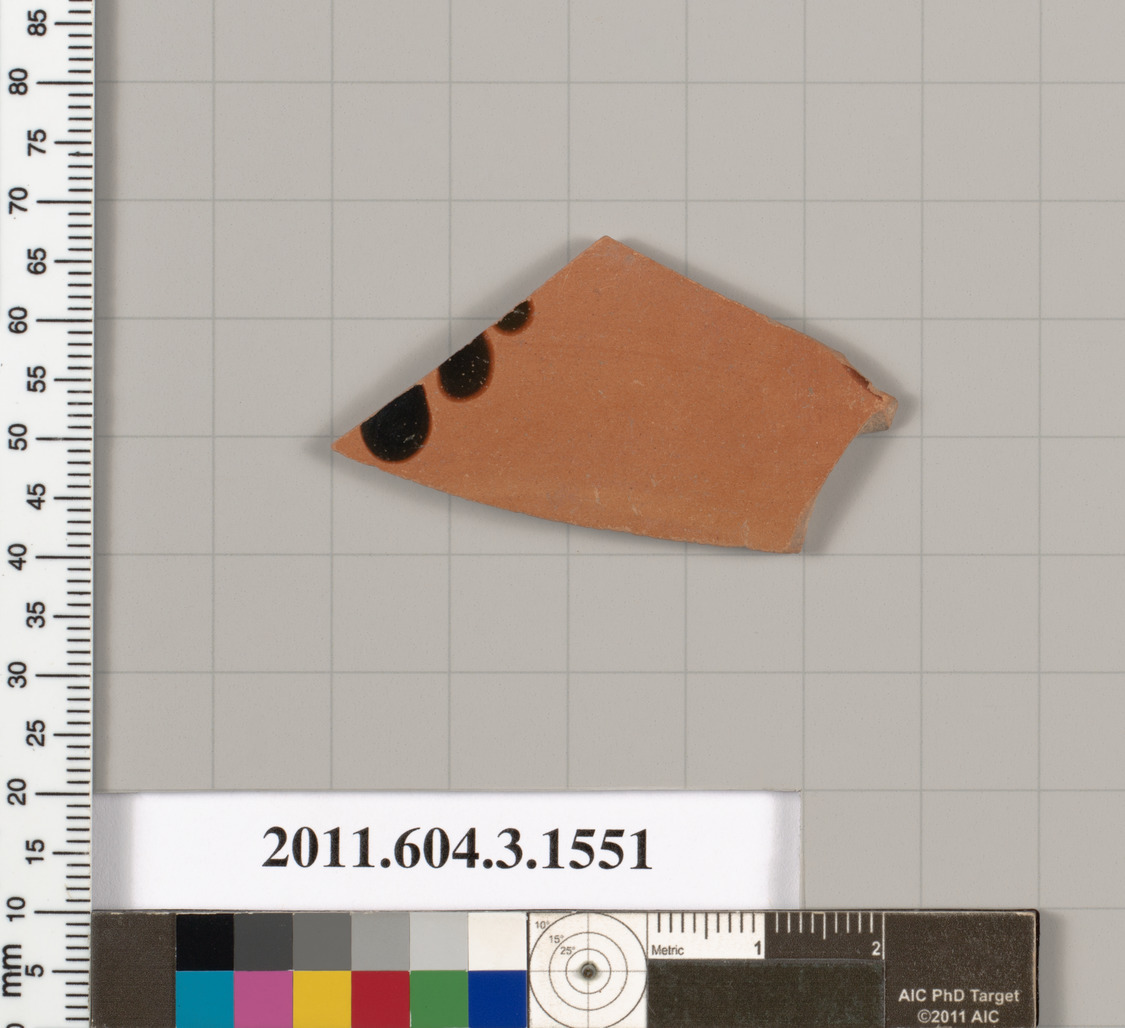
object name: kylix fragment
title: Terracotta fragment of a kylix (drinking cup)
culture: greek, attic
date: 550-526 BCE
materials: terracotta